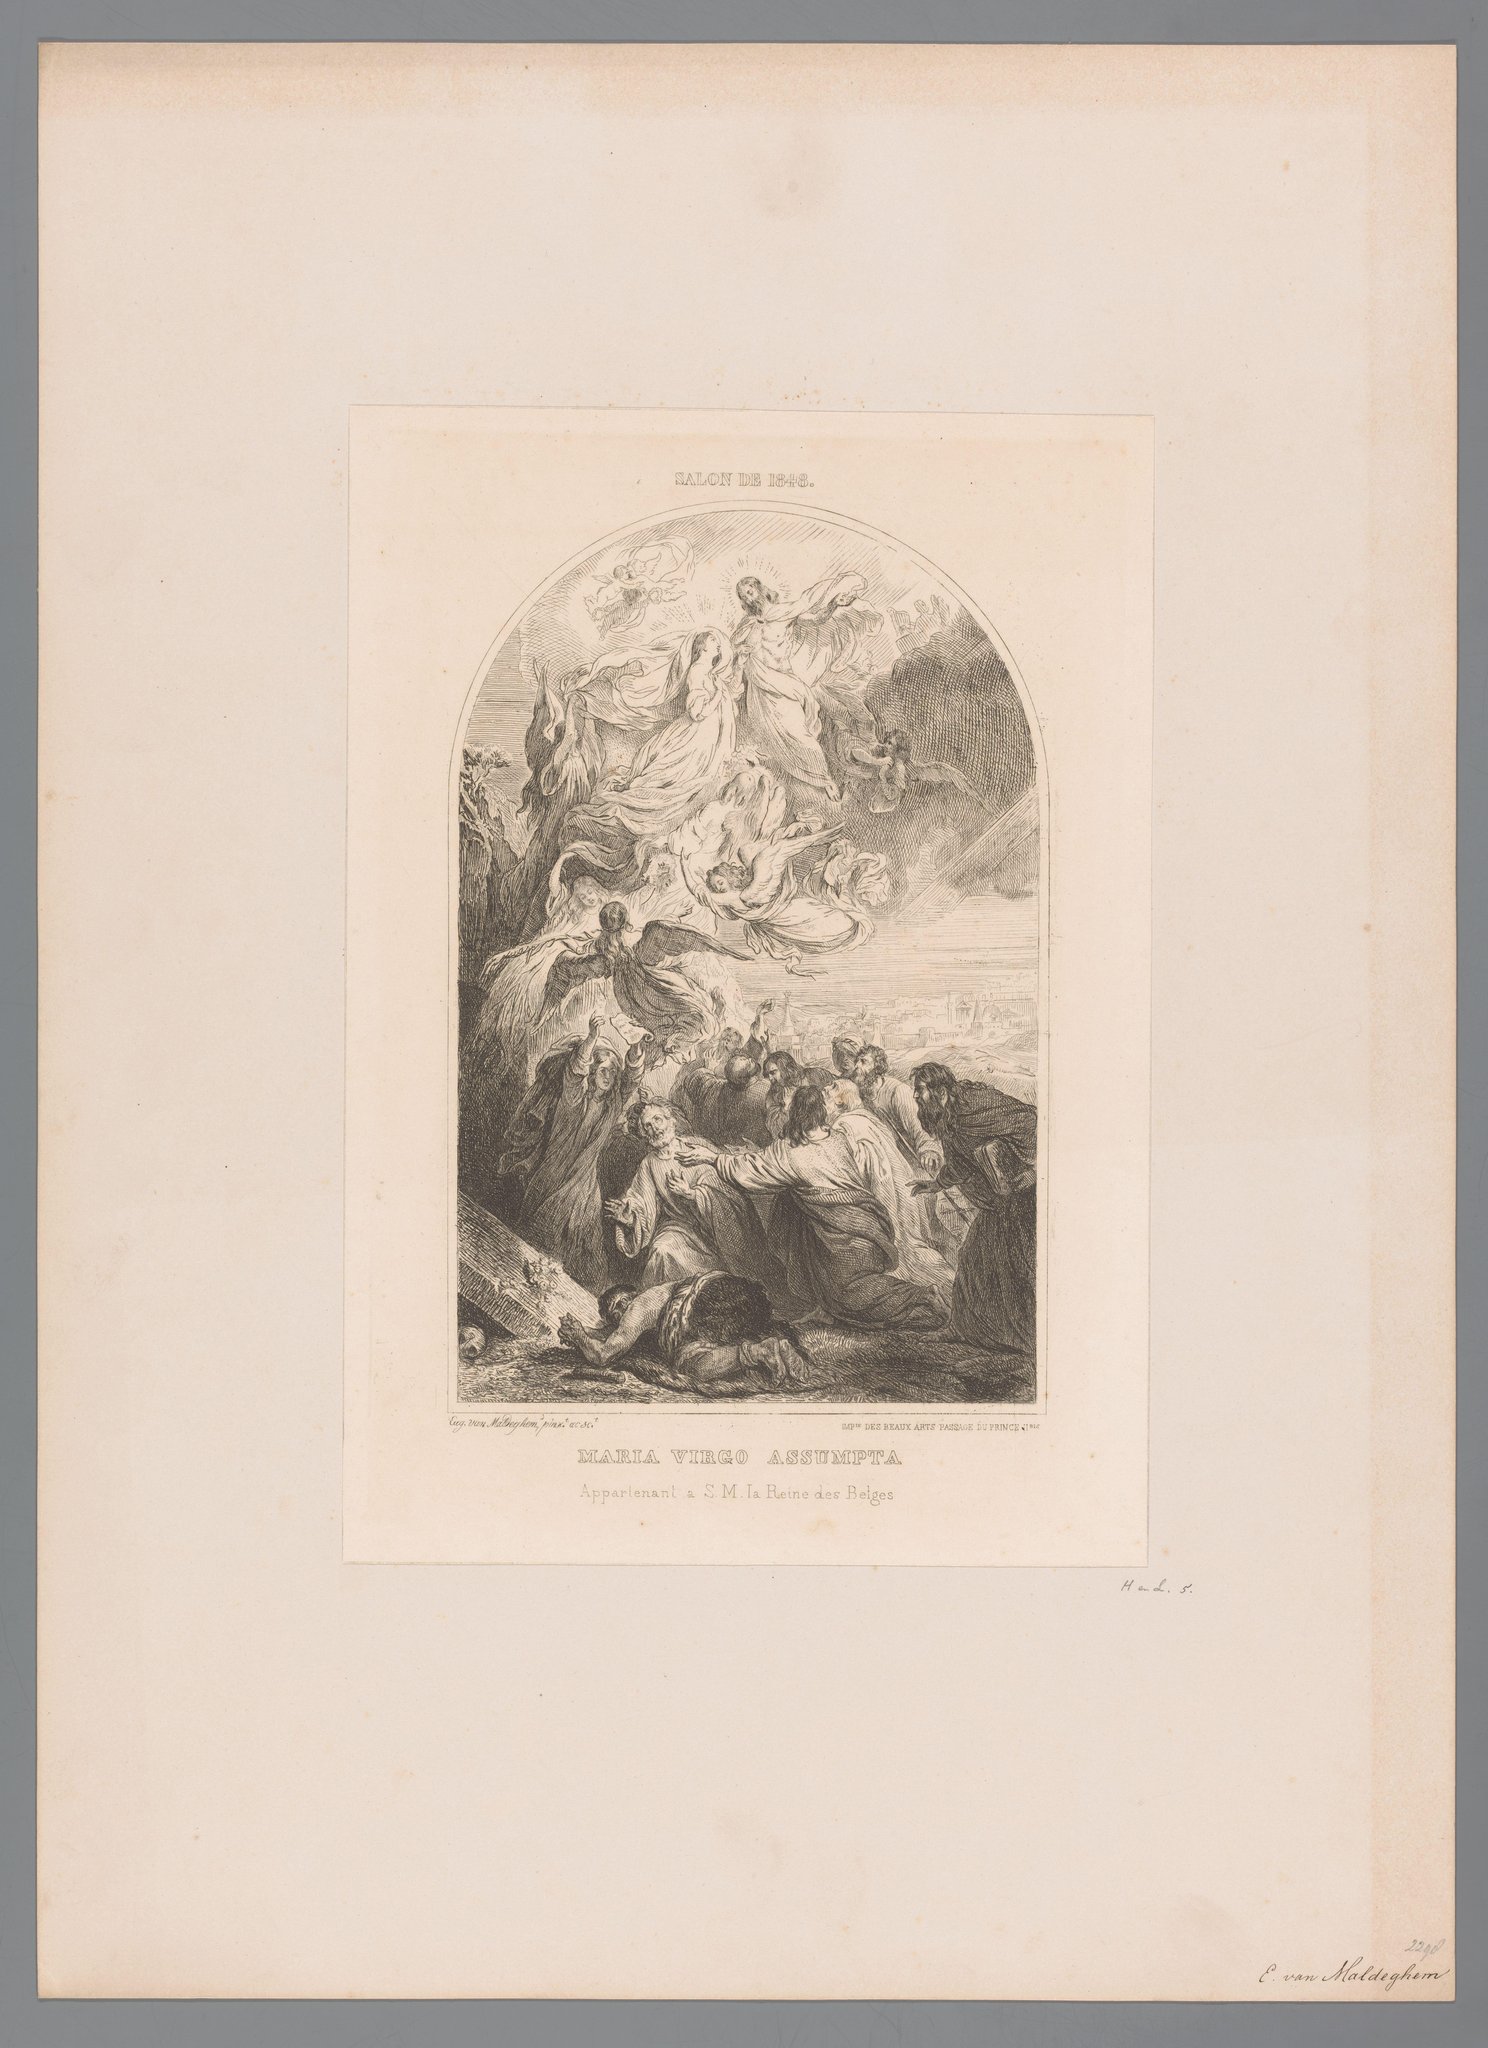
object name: print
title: Hemelvaart van Maria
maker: eugène van maldeghem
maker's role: draughtsman, painter, print maker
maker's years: 1813-1867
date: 1848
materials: paper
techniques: etching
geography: brussels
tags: the assumption of mary ('assumptio corporis'): she is borne into heaven by angels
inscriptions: collector's mark: Lugt 2228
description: De prentmaker vervaardigde een schilderij met eenzelfde scène voor de kapel van de koningin van België (destijds Louise Marie d'Orléans).